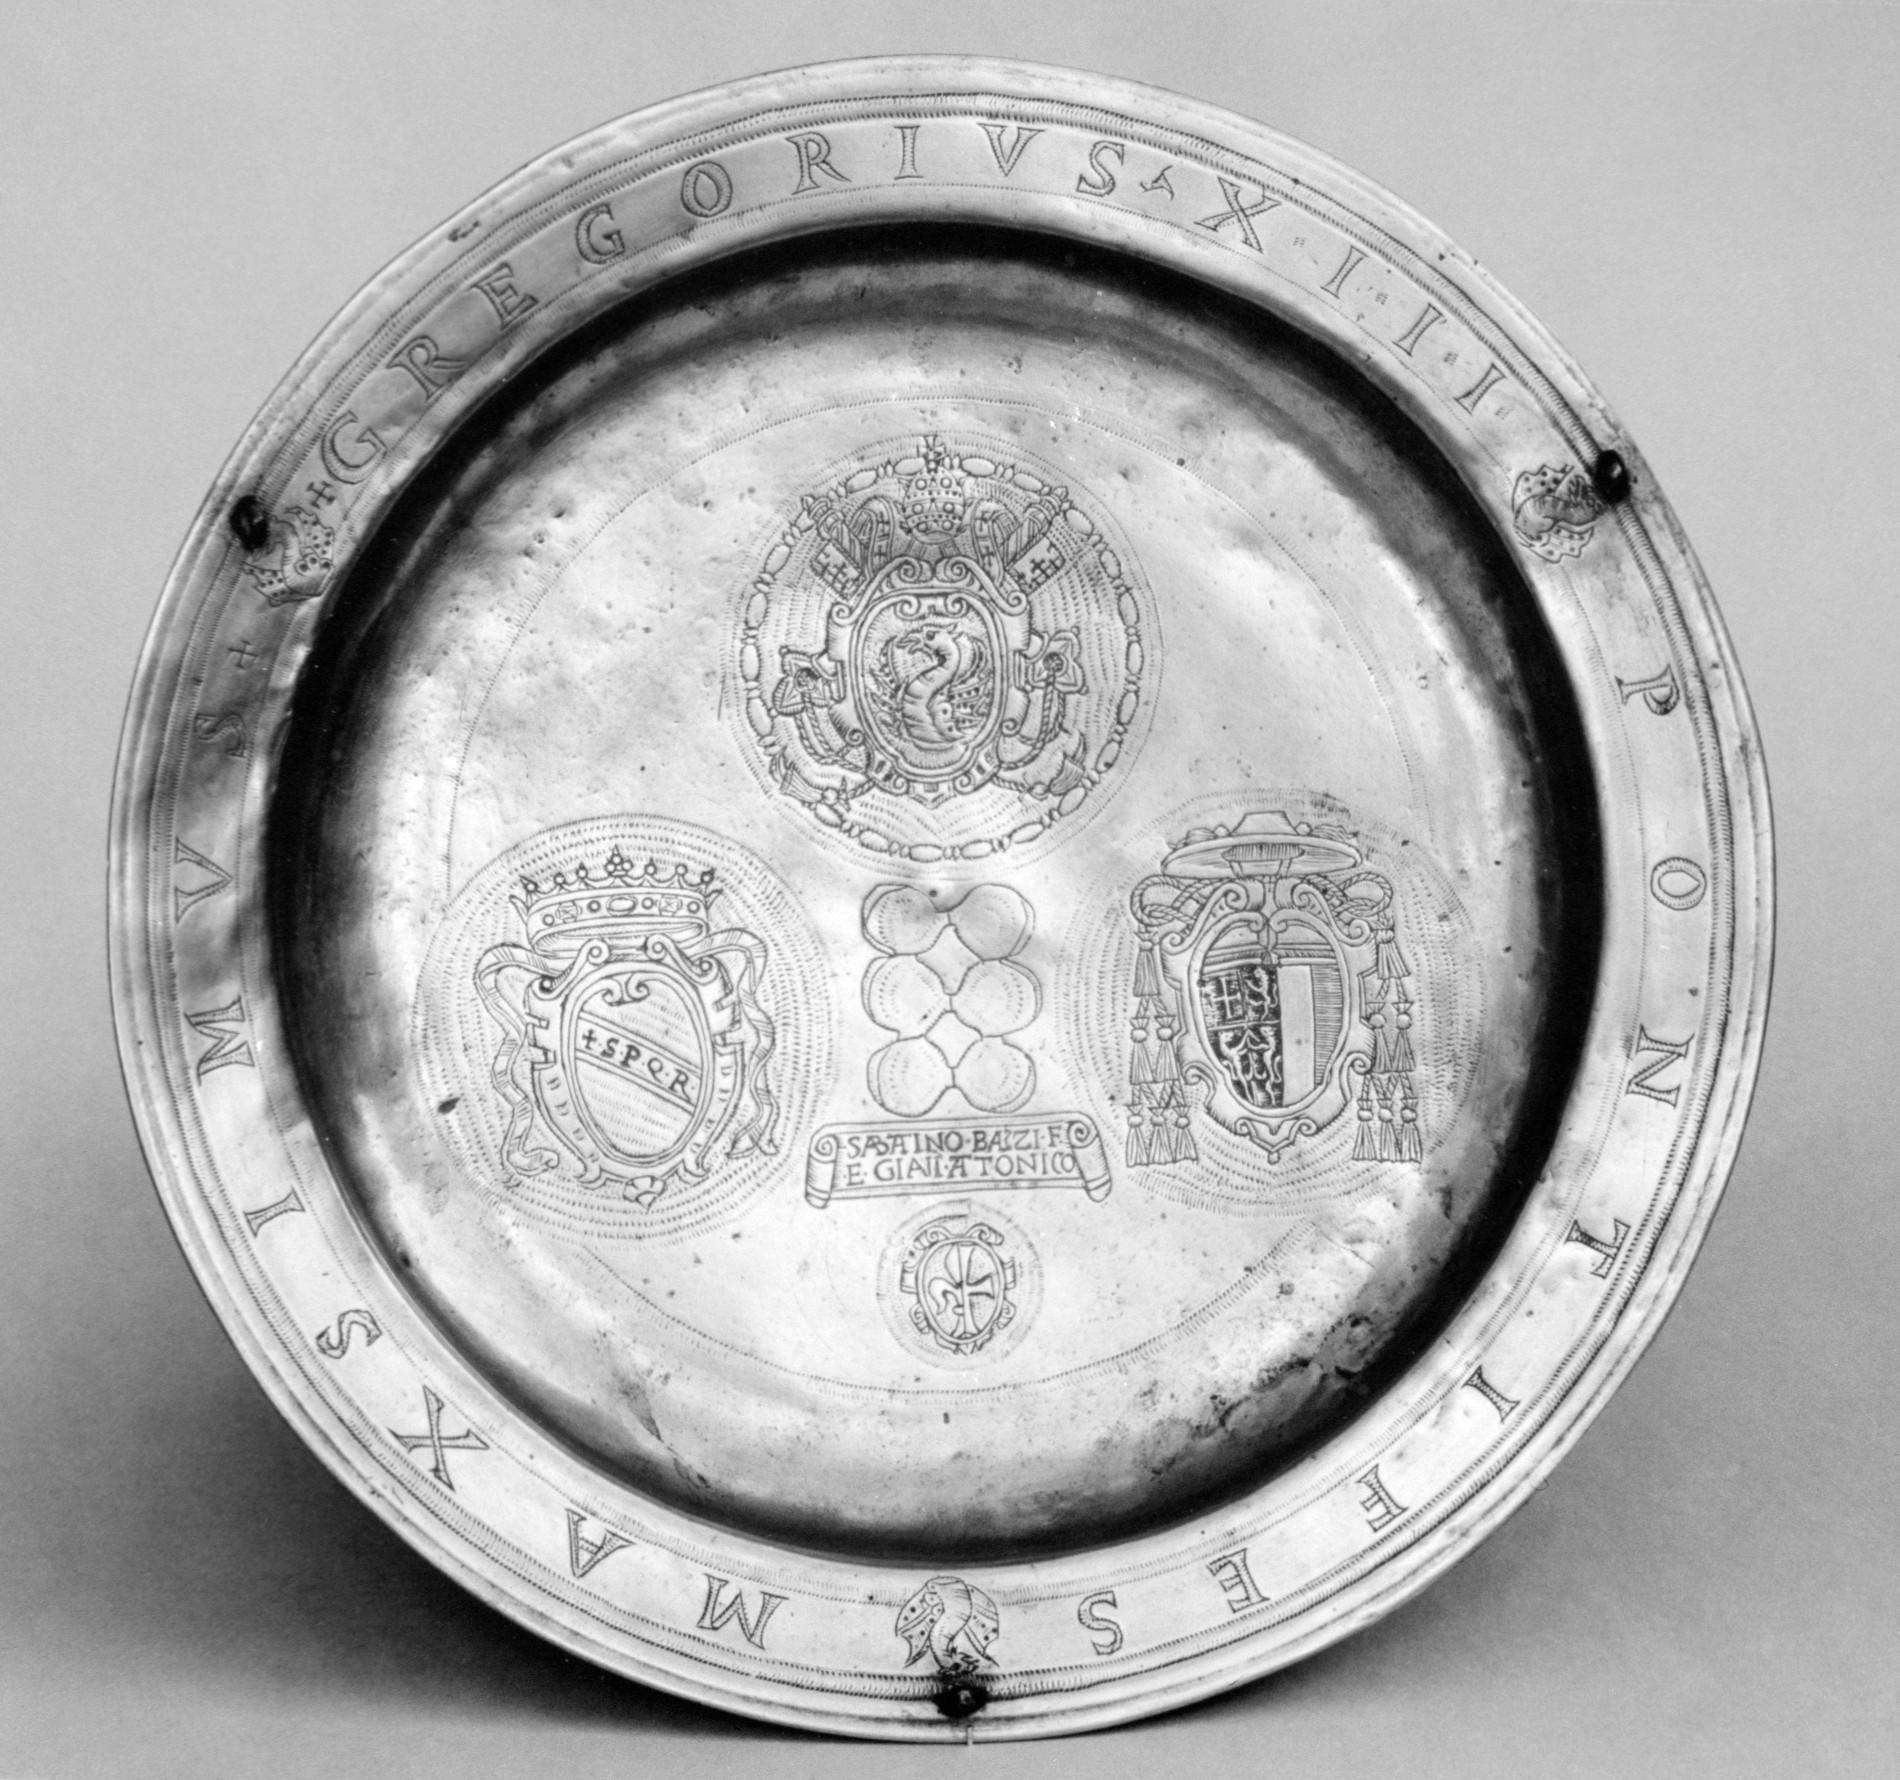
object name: scale pan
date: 1572-1584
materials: brass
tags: coat of arms